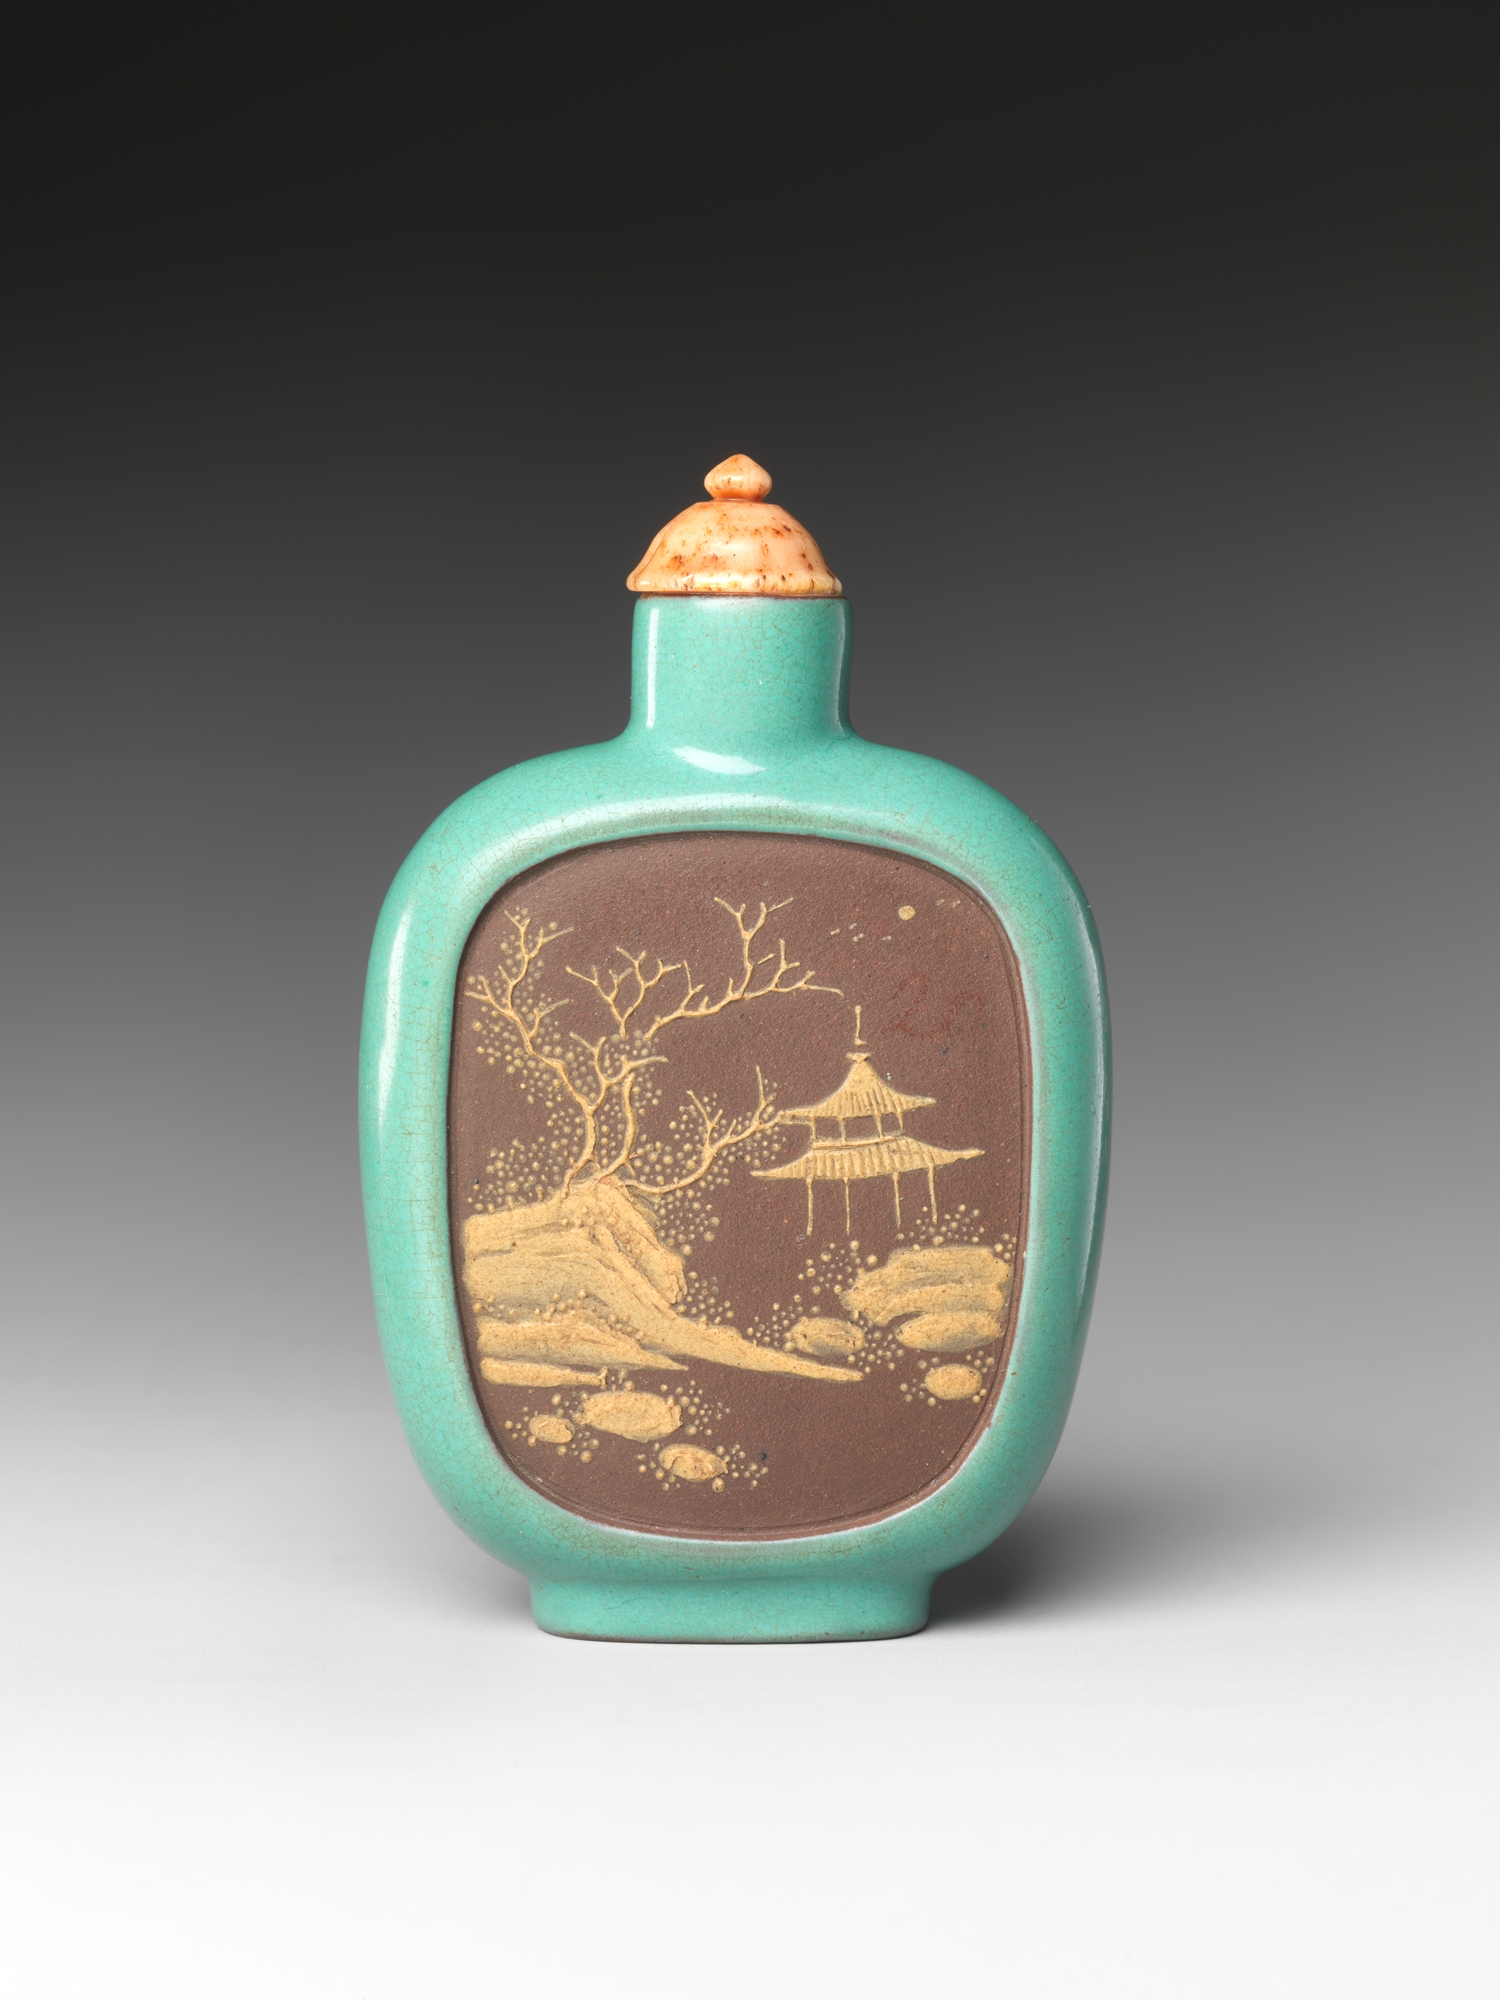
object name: snuff bottle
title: Snuff Bottle with Landscape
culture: chinese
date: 1767-1833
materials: coral, earthenware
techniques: glazing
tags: landscapes